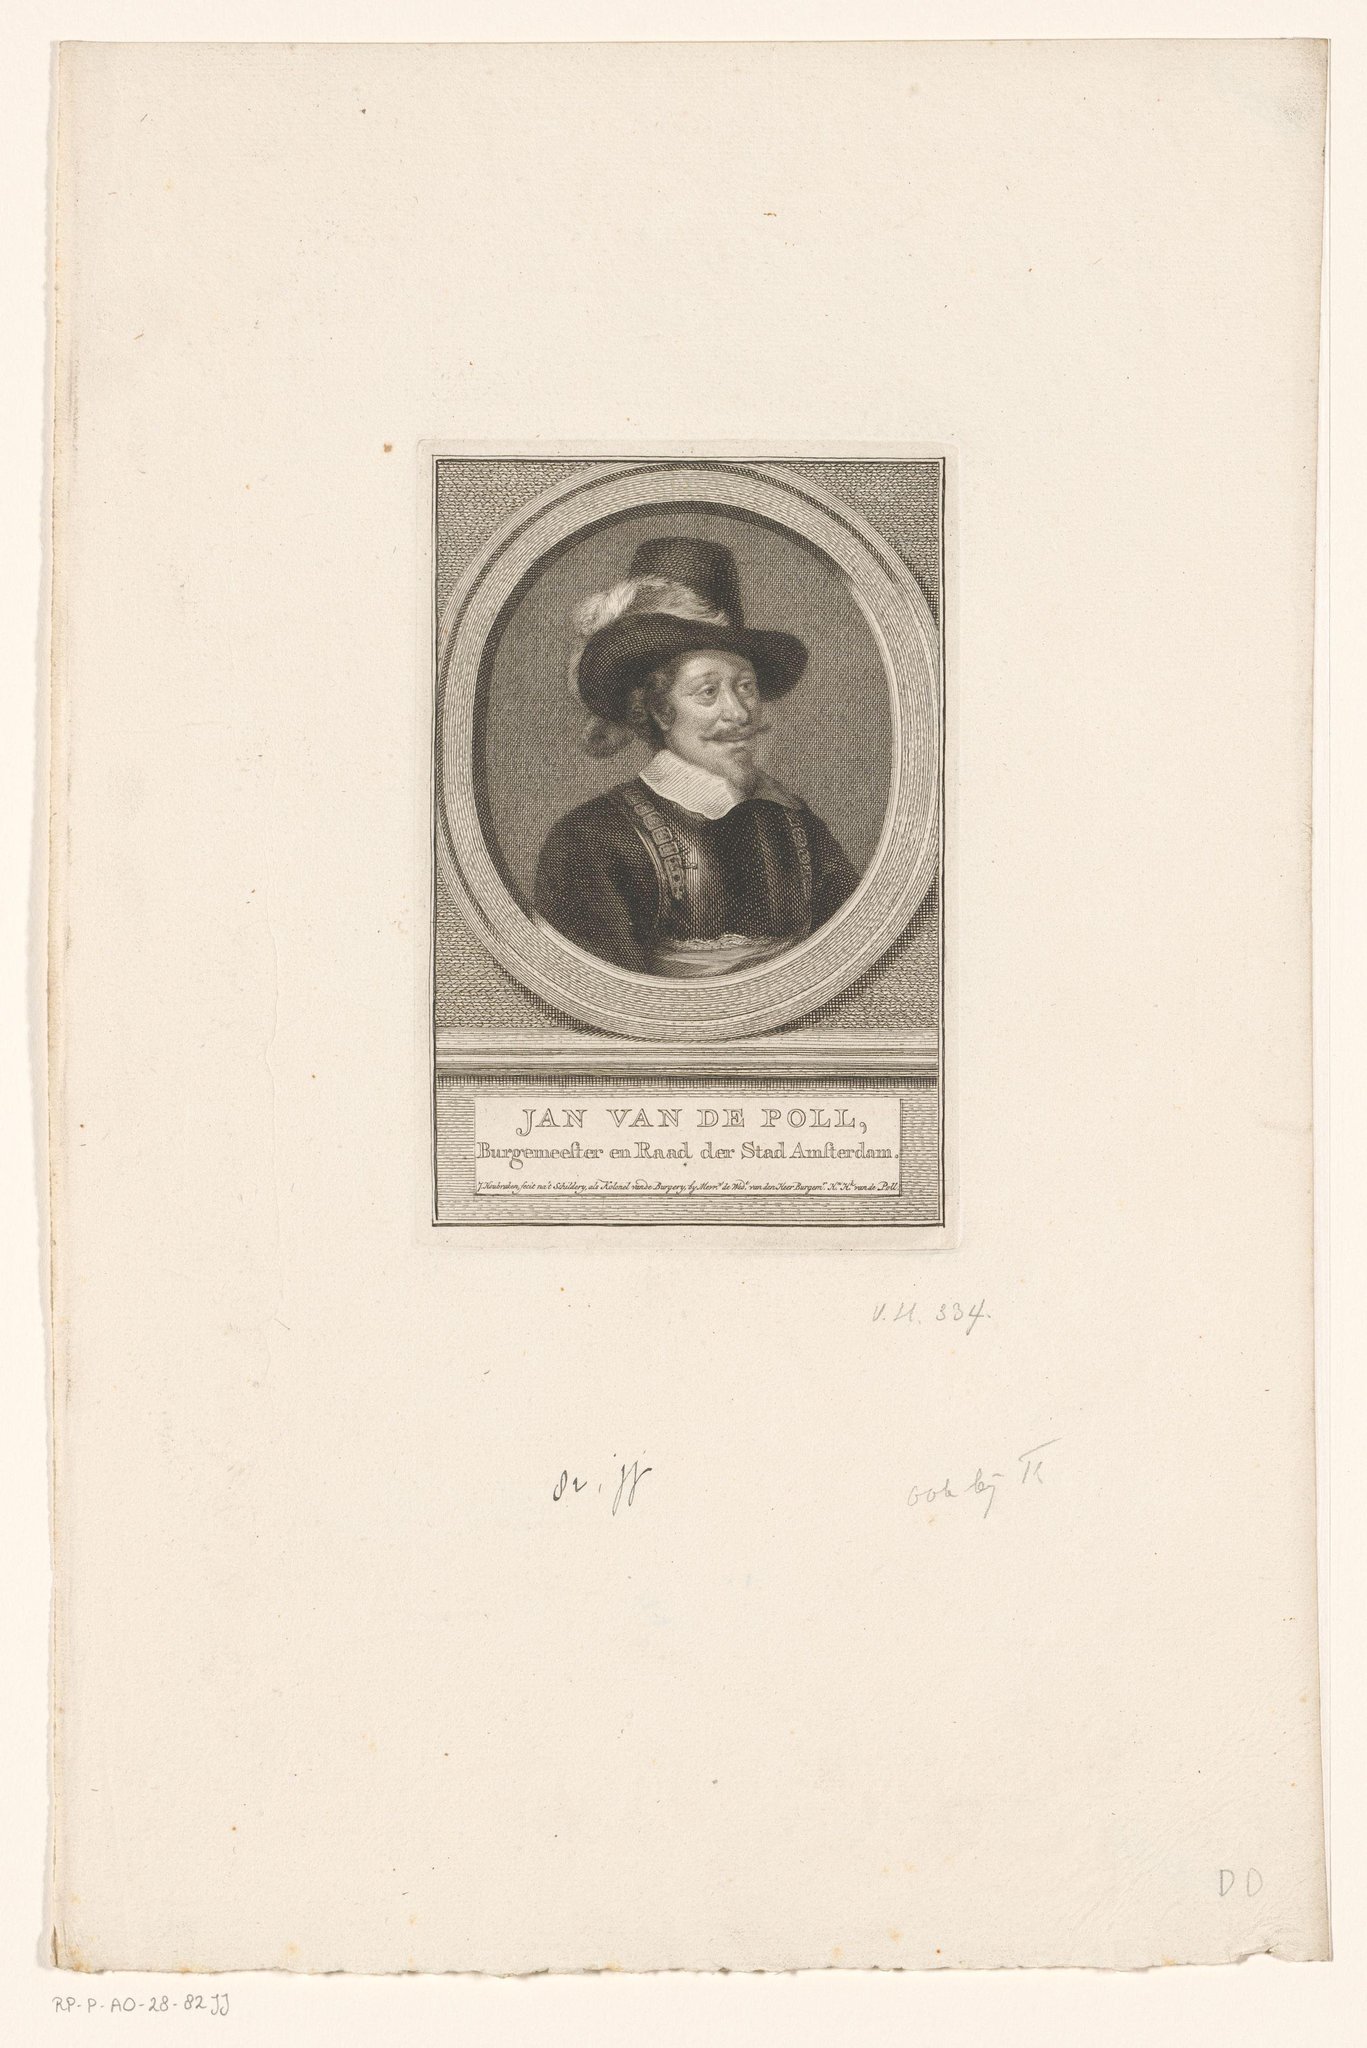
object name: print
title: Portret van Jan van de Poll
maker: jacob houbraken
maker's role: draughtsman, print maker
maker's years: 1698-1780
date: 1749-1780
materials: paper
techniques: engraving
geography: amsterdam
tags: historical persons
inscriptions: collector's mark: Lugt 2228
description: Deze prent is oorspronkelijk bedoeld als aanvulling op Jan Wagenaars ‘Vaderlandsche historie’* en was zo vanaf 1796 verkrijgbaar bij Johannes Allart te Amsterdam. Voor de advertentie waarin Allart de 60 portretten en 7 platen, allen gegraveerd door Houbraken, ter aanvulling op Wagenaars ‘Vaderlandsche historie’ aanbiedt, zie RP-P-OB-77.766. *Van dit werk zijn in de achttiende eeuw meerdere uitgaves verschenen, zoals: Wagenaar, Jan. Vaderlandsche historie, vervattende de geschiedenissen der Vereenigde Nederlanden (…). 21 delen. Amsterdam: Isaak Tirion, 1749-1759. Wagenaar, Jan. Vaderlandsche historie, vervattende de geschiedenissen der nu Vereenigde Nederlanden (…). 21 delen. Amsterdam: weduwe Isaak Tirion, 1770. Wagenaar, Jan. Vaderlandsche historie, vervattende de geschiedenissen der nu Vereenigde Nederlanden (…). 21 delen. Amsterdam, Leiden, Dordrecht en Harlingen: P. Schouten e.a., 1782. Wagenaar, Jan. Vaderlandsche historie, vervattende de geschiedenissen der nu Vereenigde Nederlanden (…). 21 delen. Amsterdam: Johannes Allart, 1790-1796.